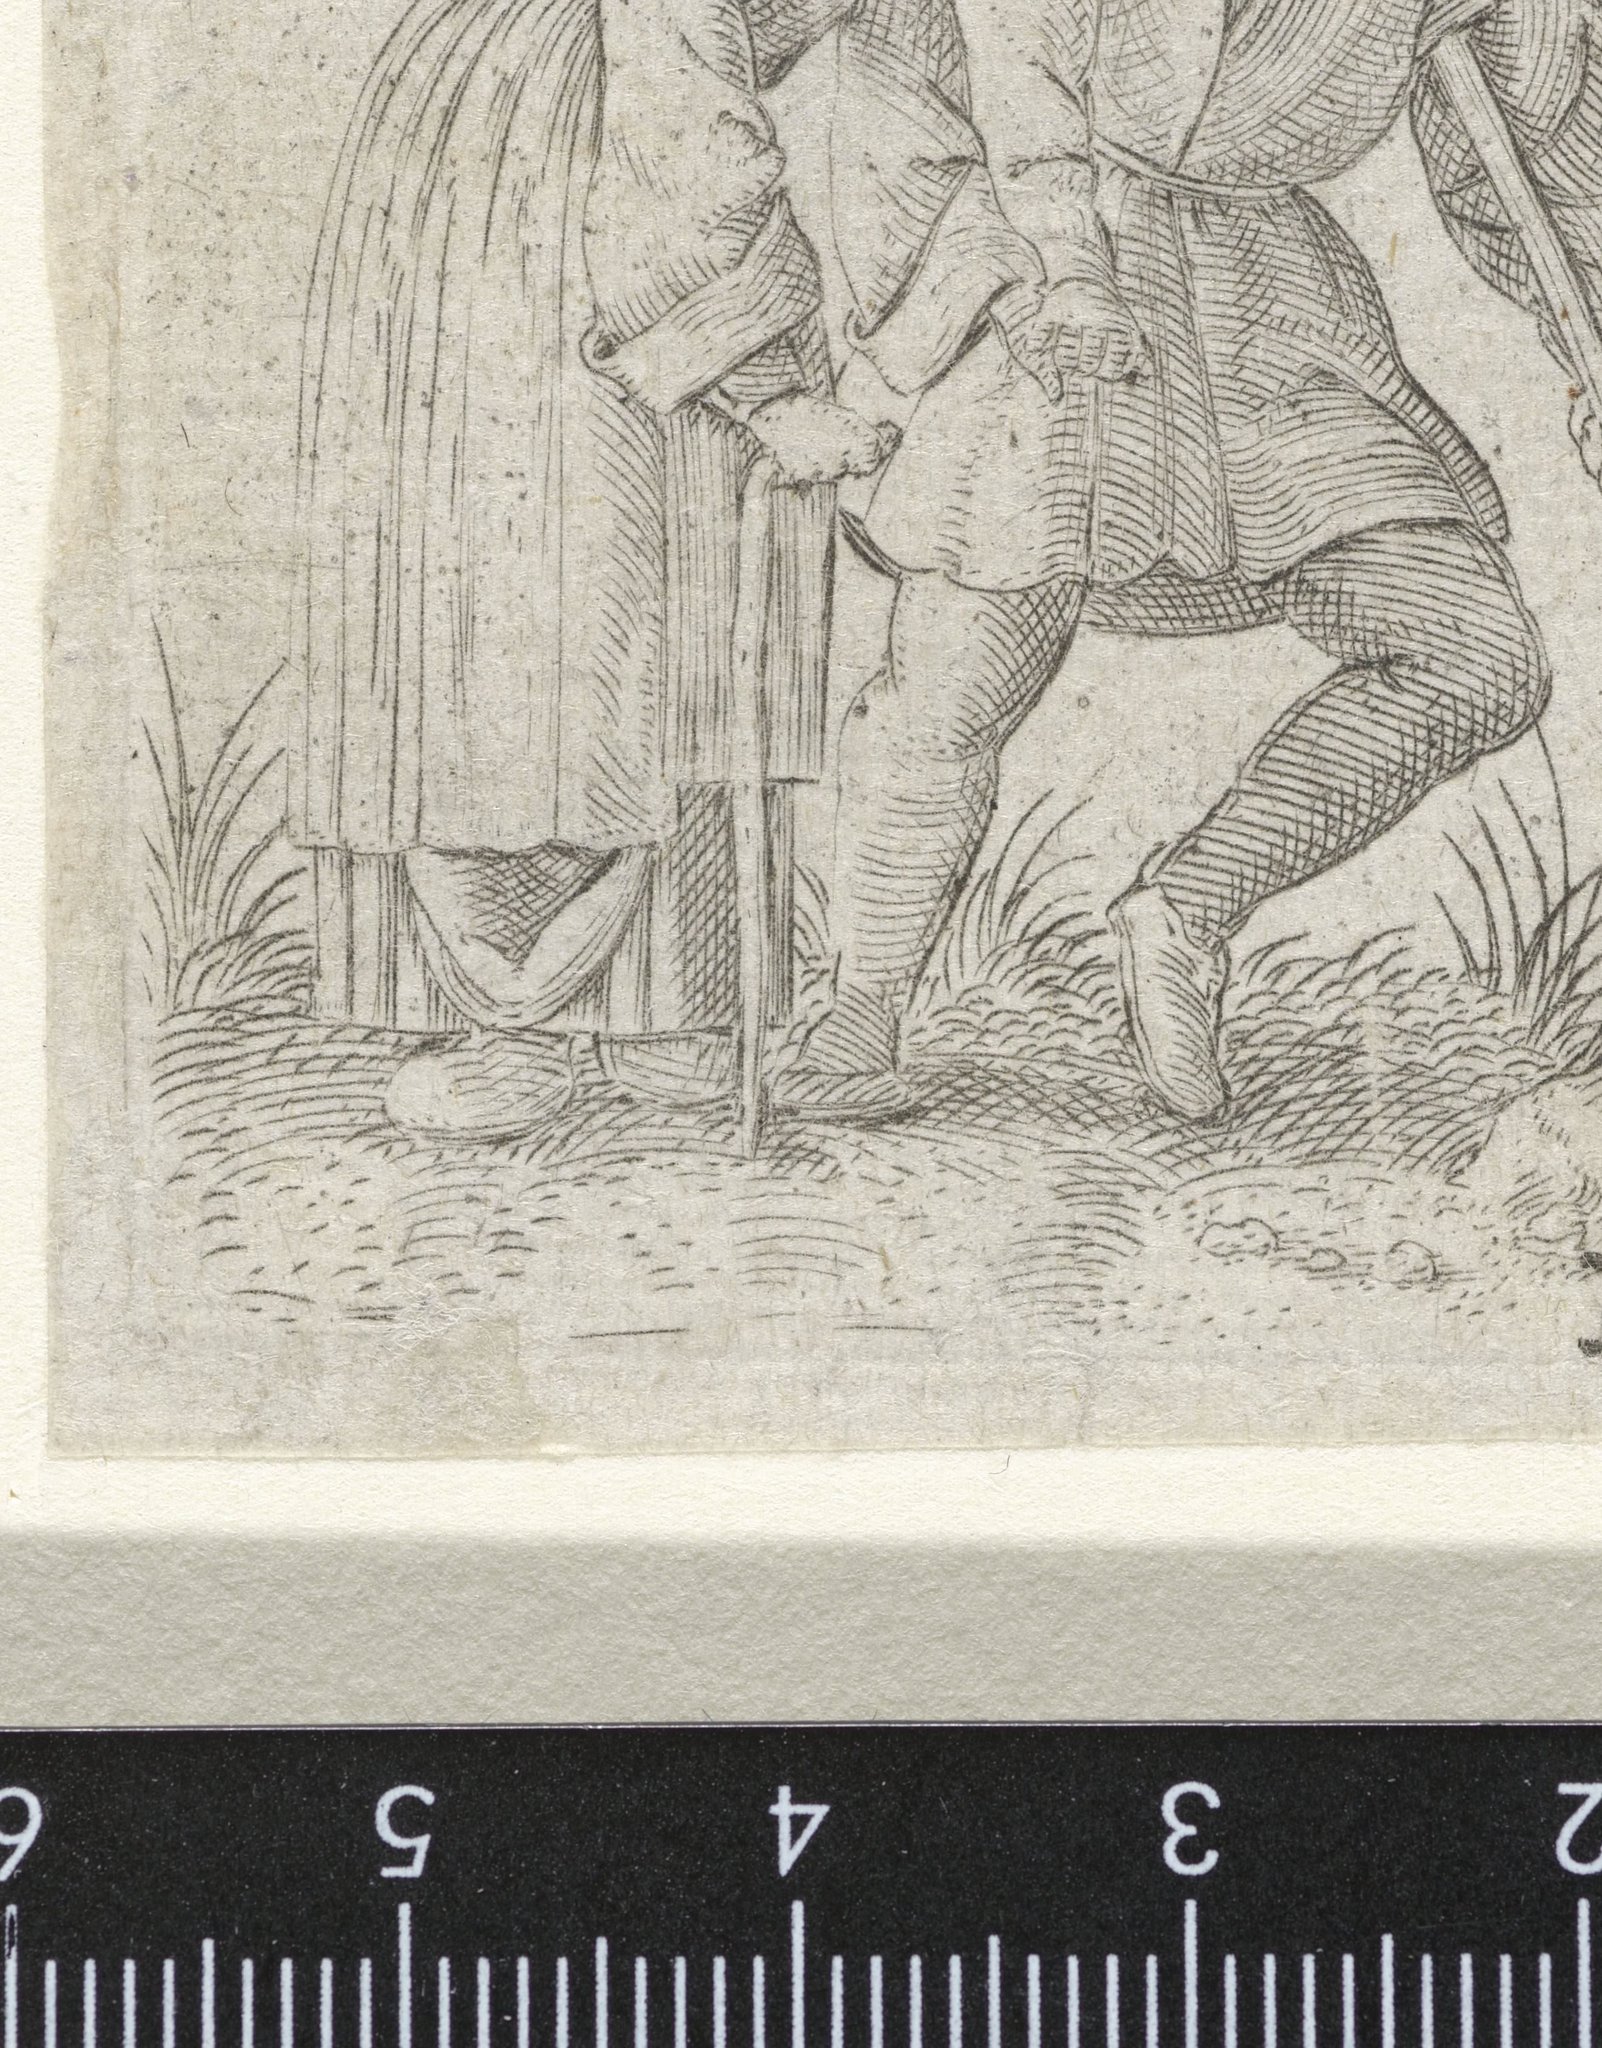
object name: print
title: Paar gekleed als burgers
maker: cornelis massijs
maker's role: painter, print maker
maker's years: 1510-1557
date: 1577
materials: paper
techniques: engraving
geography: antwerp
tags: dancing, crutches, one pair dancing; man and woman dancing as a couple, social stratification, social groups, bourgeoisie, middle class, citizens, burghers, folk costume, regional costume, beggar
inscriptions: collector's mark: Lugt 1967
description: In de tijd waarin deze serie ontstond was 'kreupel' een generiek woord om een lichamelijke beperking aan het onderlichaam te beschrijven. Deze serie is sociale satire. Een man met een baret op het hoofd, leunend op een kruk, houdt de hand vast van een vrouw, die op een stok leunt. Zij gaan gekleed als burgers. Genummerd: 6.